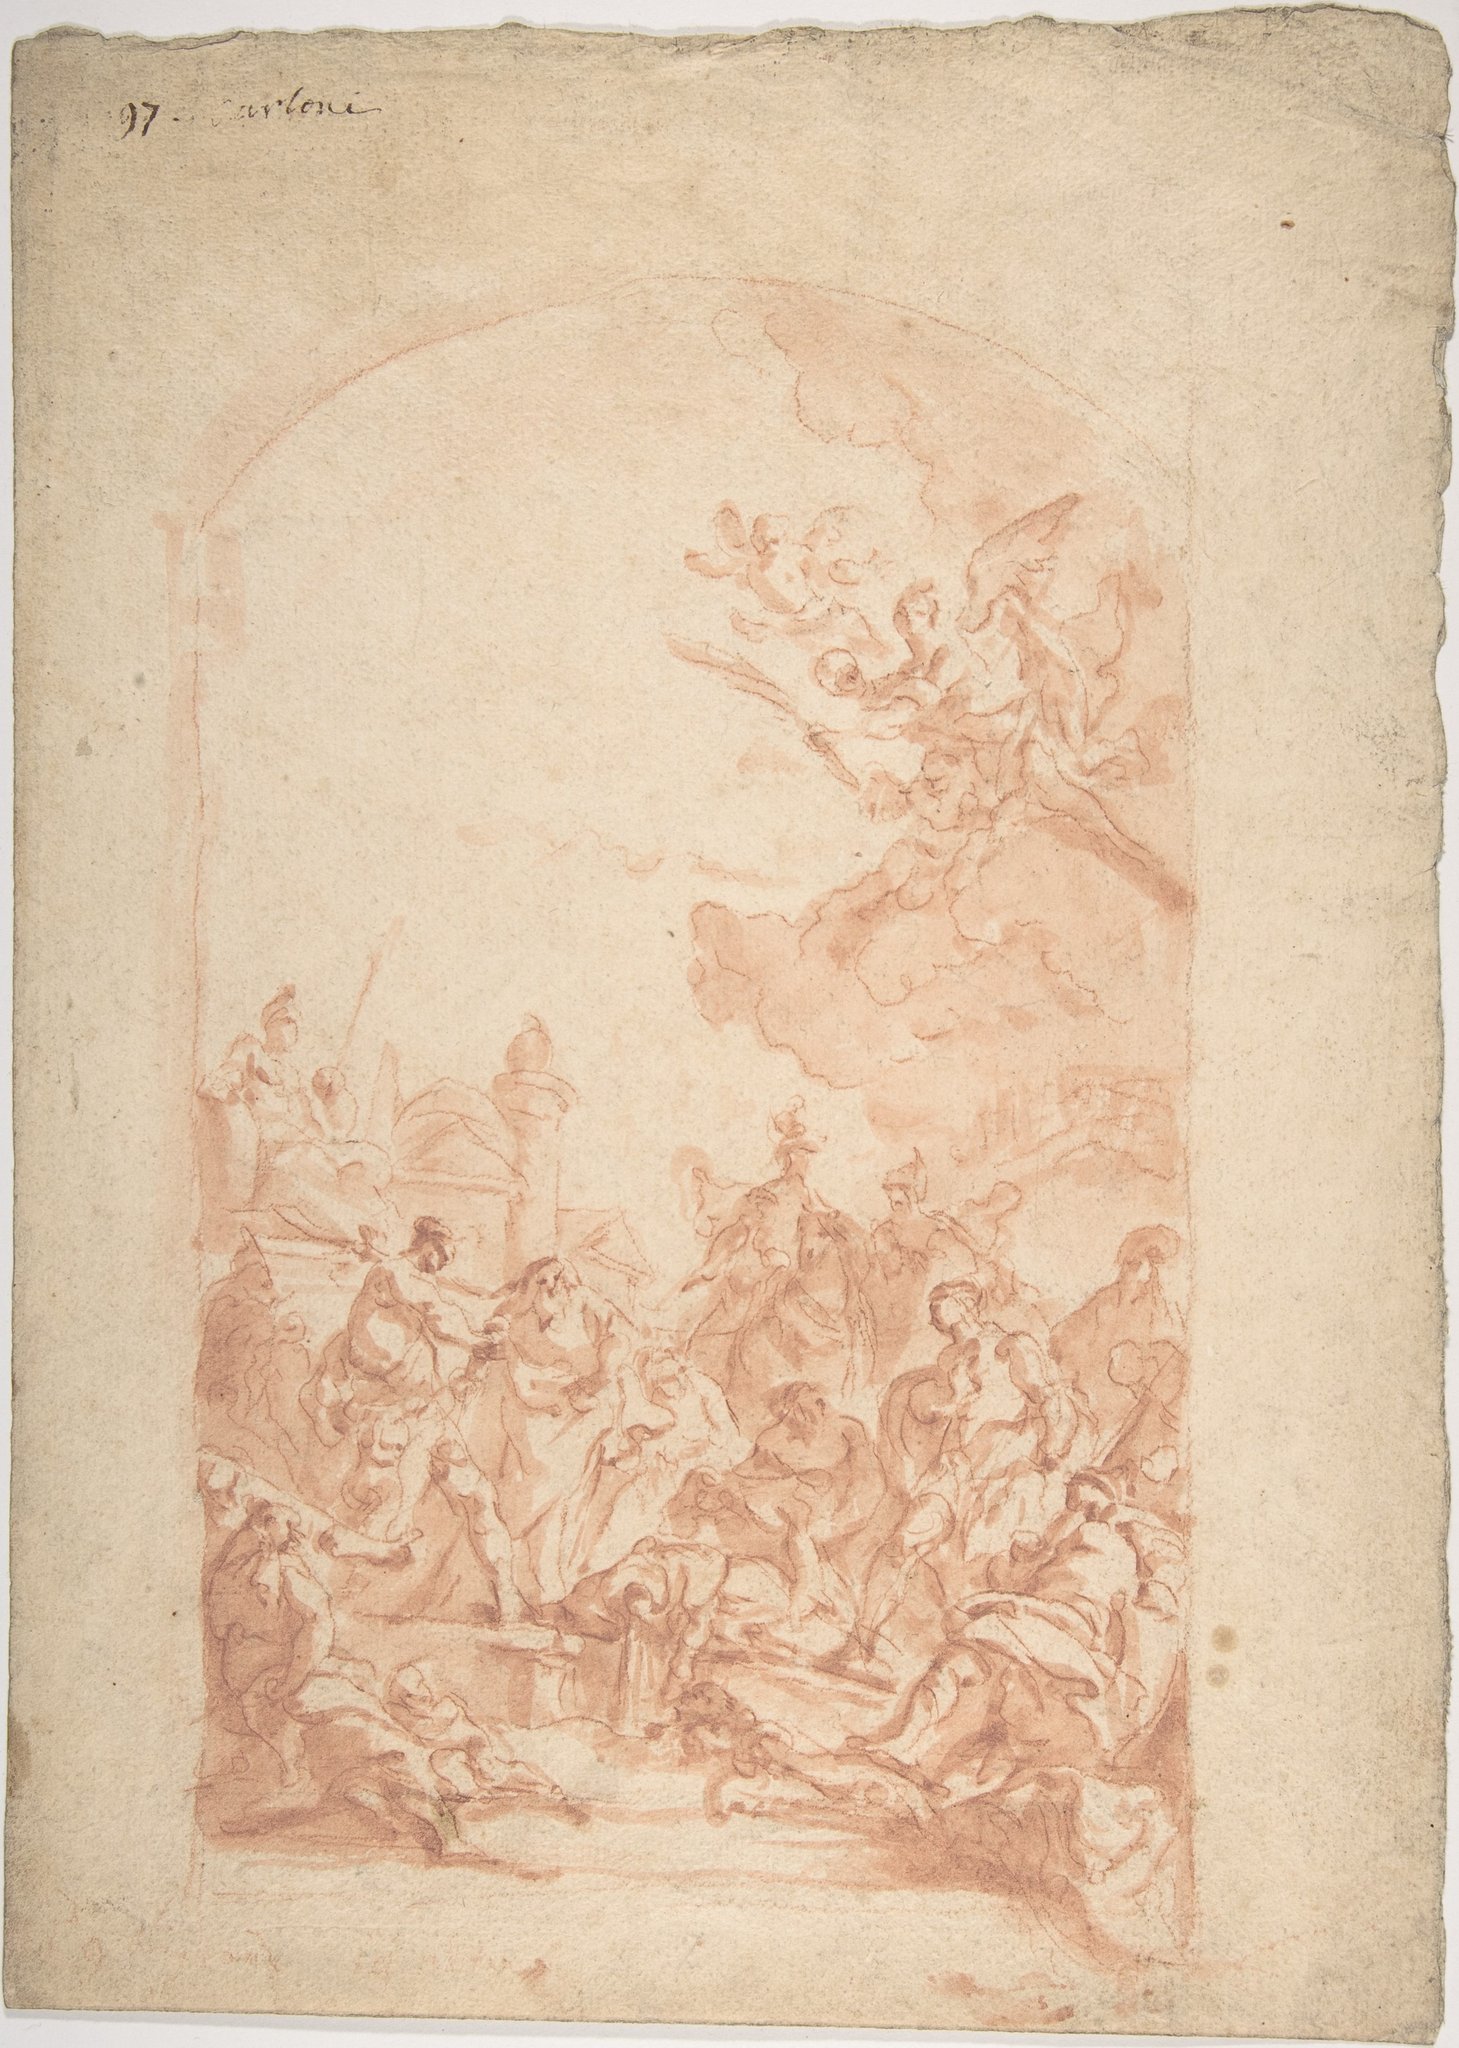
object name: drawing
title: The Decapitation of a Male Saint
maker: carlo innocenzo carloni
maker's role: artist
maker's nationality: italian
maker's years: 1686-1775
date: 1686-1775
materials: chalk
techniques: brush, wash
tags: saints,crowd